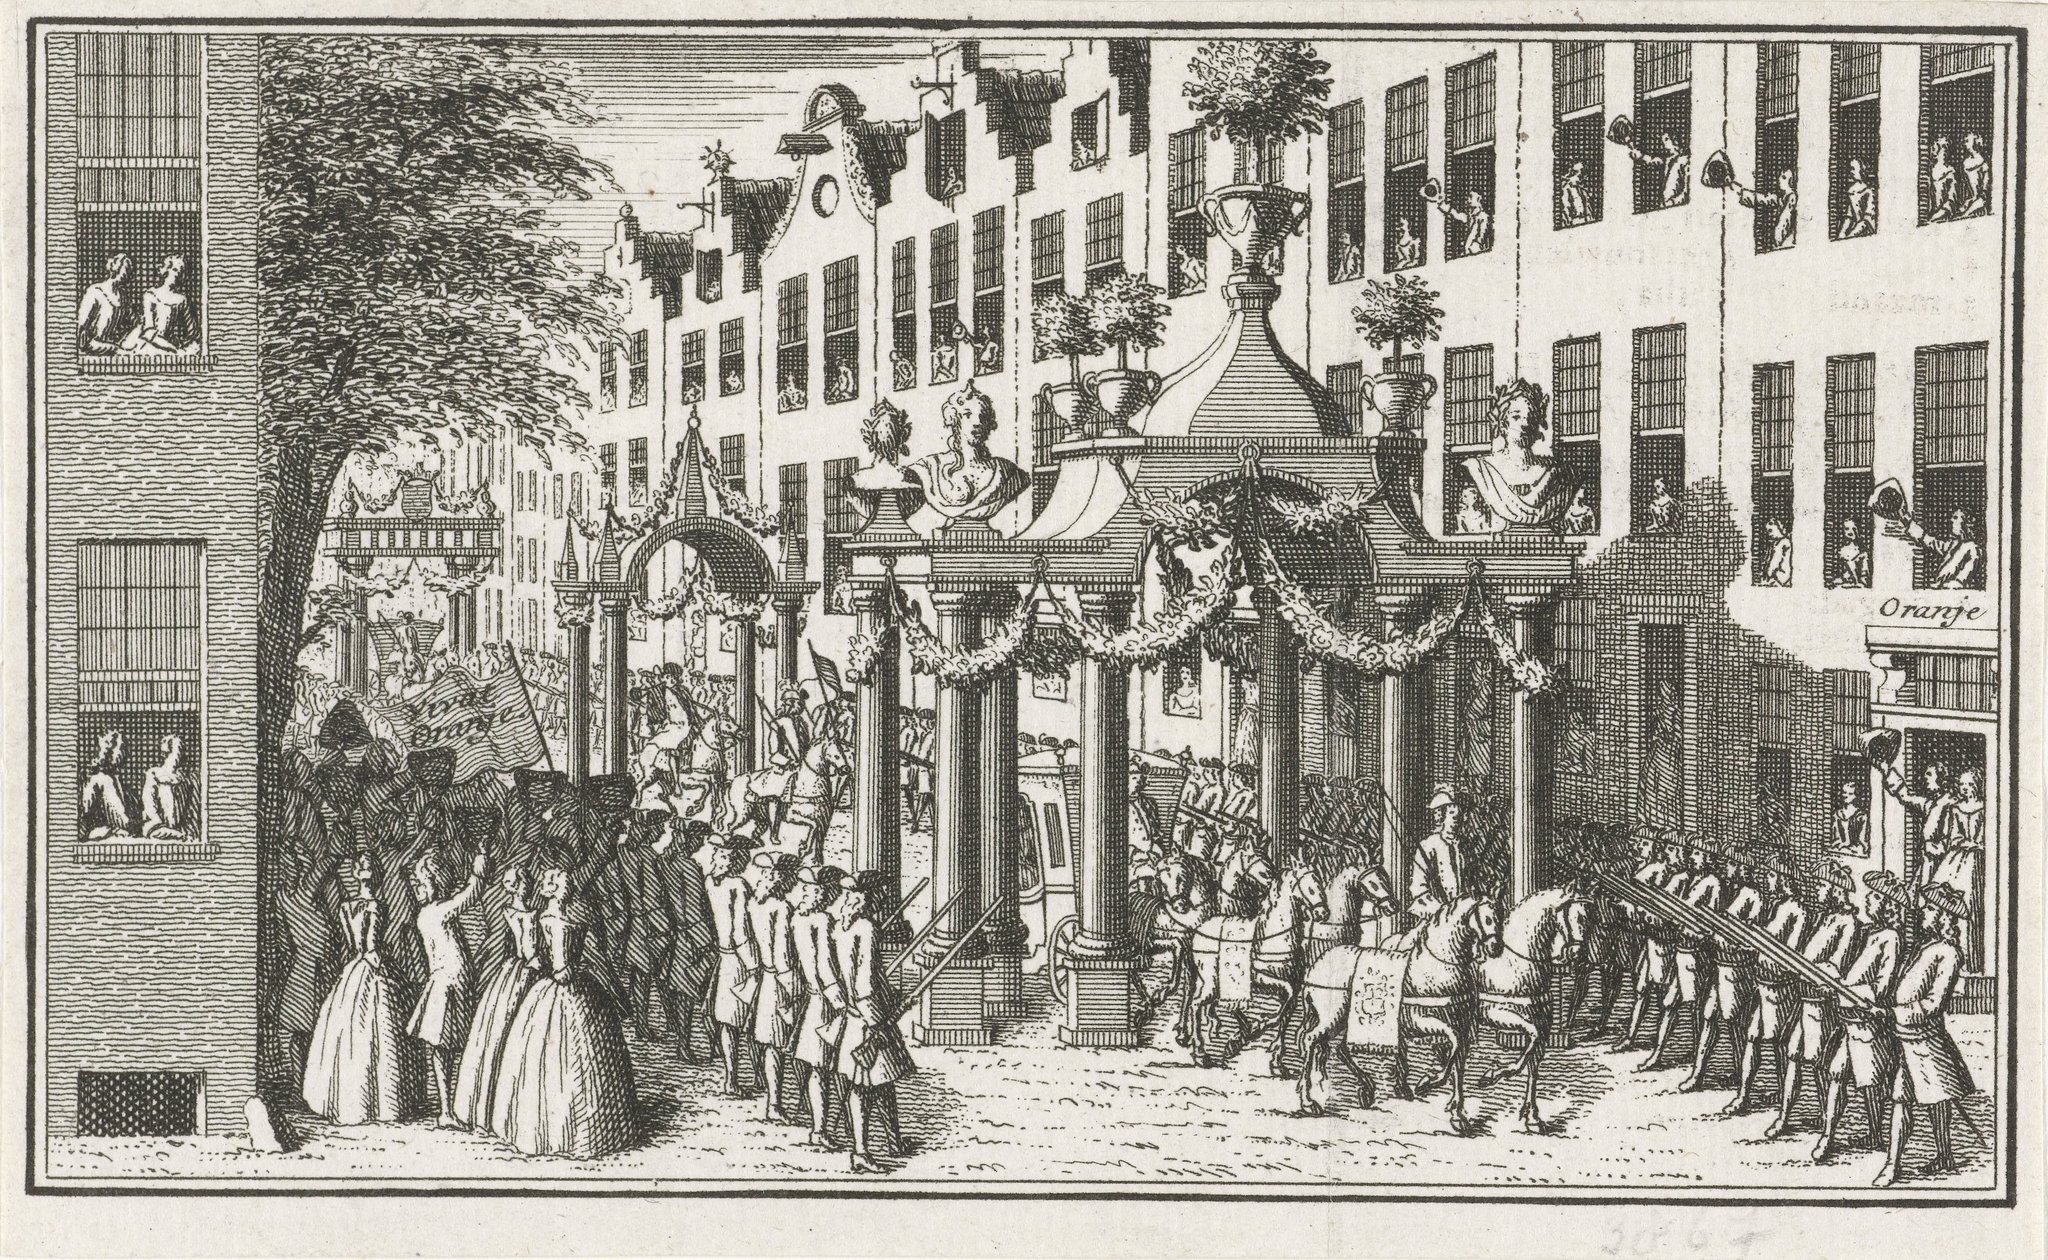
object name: print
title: Inhaling van Willem IV als stadhouder te Den Haag, 1747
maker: Anonymous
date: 1747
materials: paper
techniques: etching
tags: the hague, willem iv (prins van oranje-nassau), triumphal entry and public reception, pageant, 'entrée solennelle', 'joyeuse entrée'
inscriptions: collector's mark: Lugt 2228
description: De inhaling van prins Willem IV als stadhouder te Den Haag, 14 mei 1747. De wagen met de prins rijdt door een ereboog op straat. Langs de straat een erewacht en publiek.